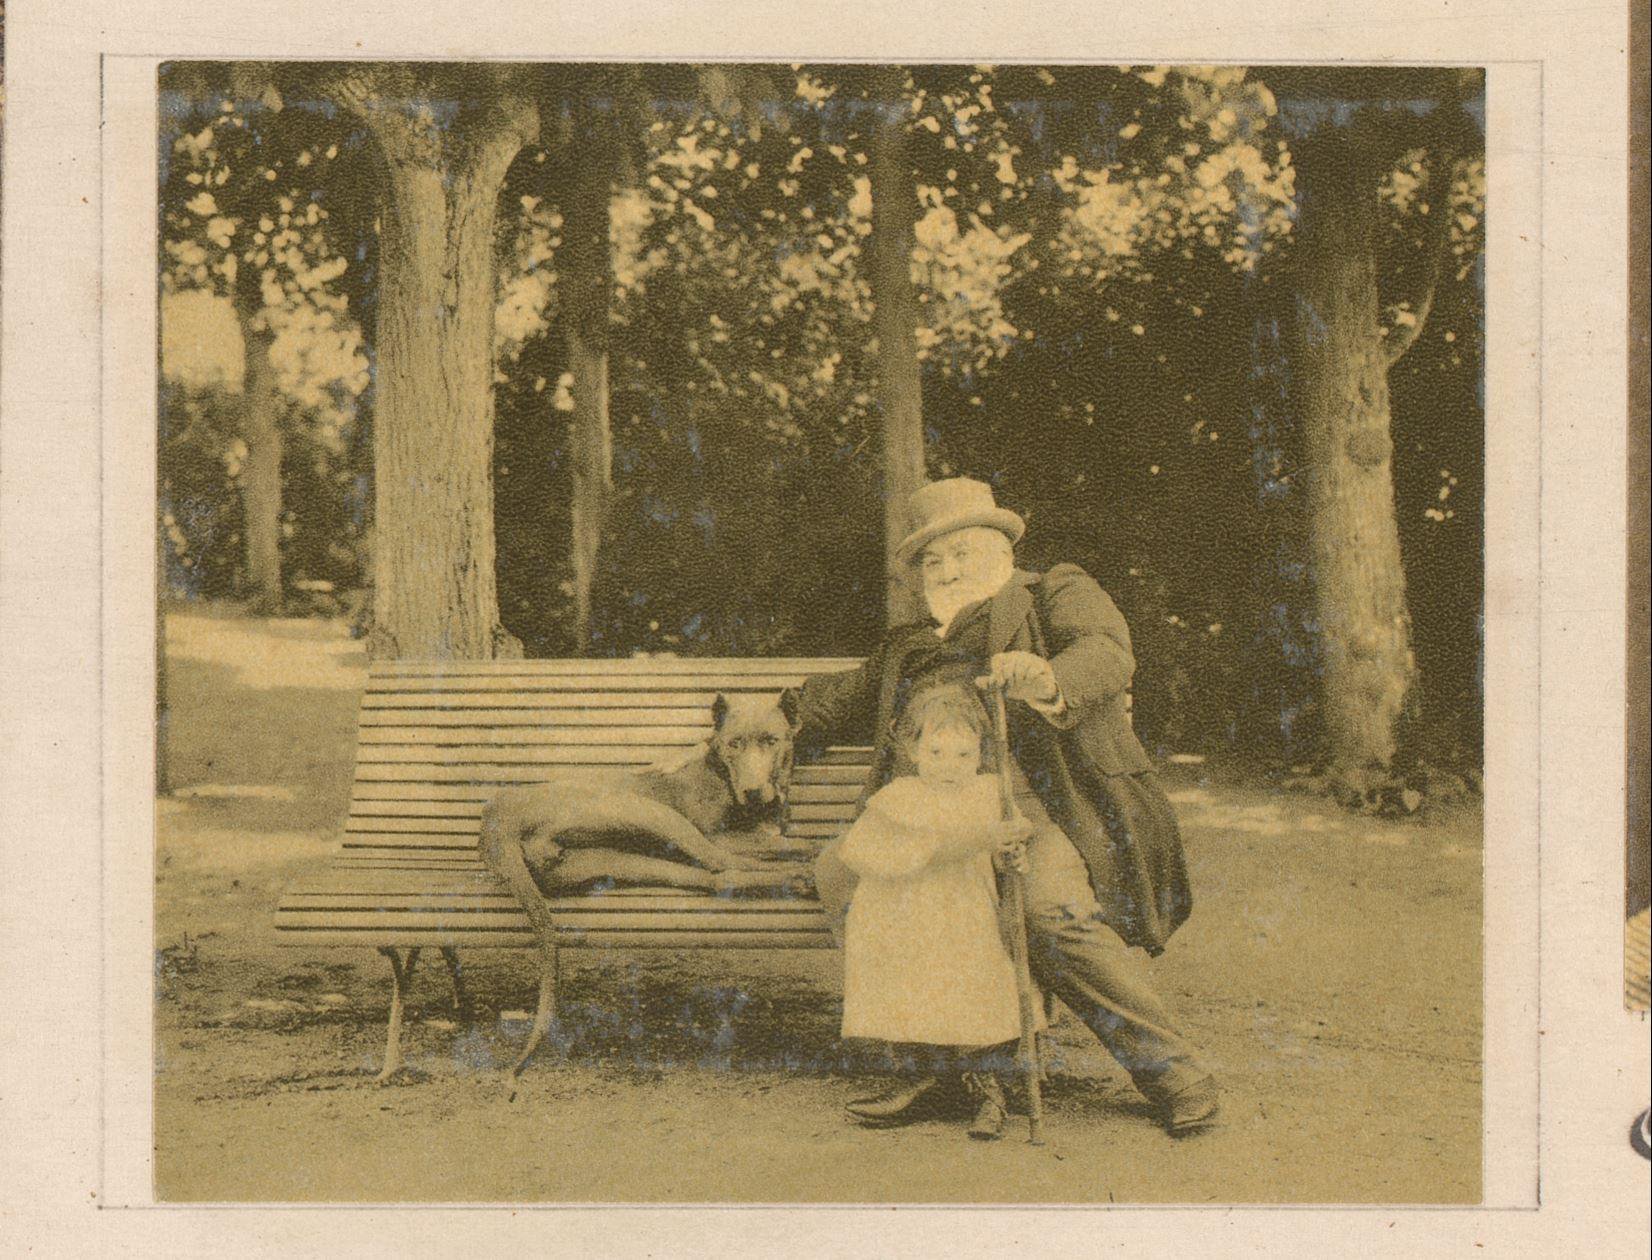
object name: photograph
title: Francisque Sarcey met kind en hond op een parkbank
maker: Anonymous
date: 1895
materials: paper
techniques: rotogravure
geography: france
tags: journalist, reporter, france